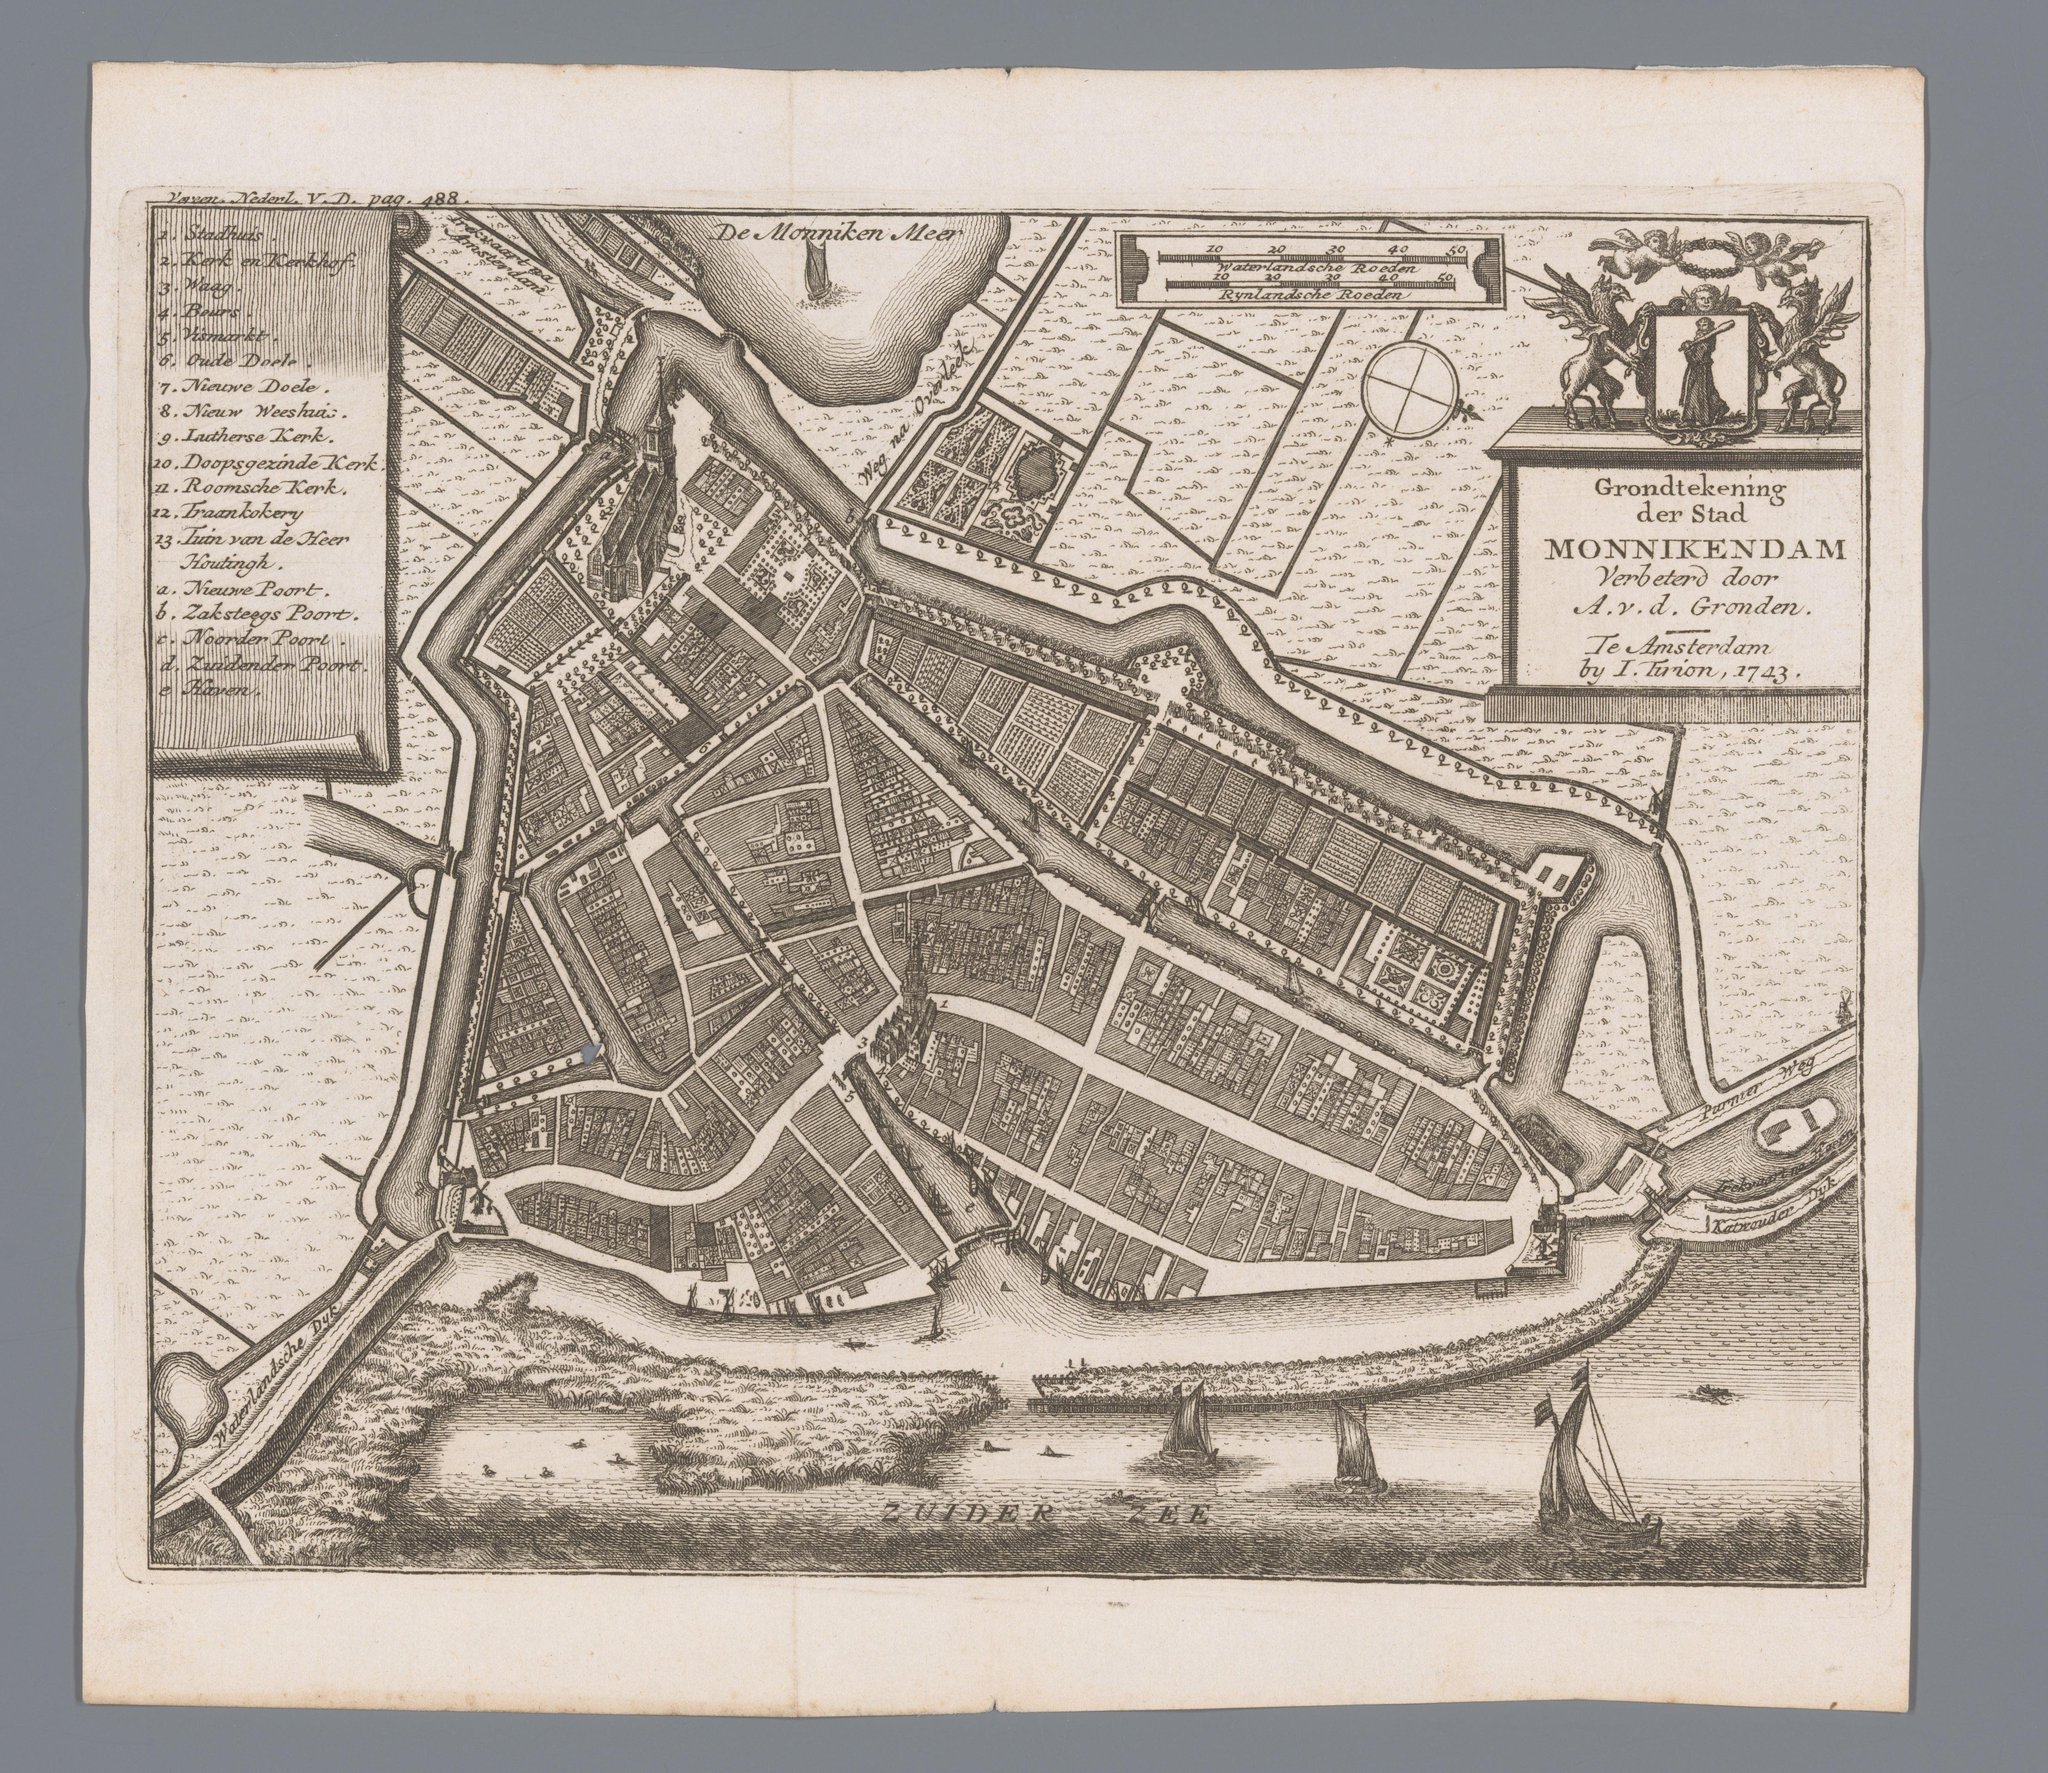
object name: area plan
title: Grondtekening der Stad Monnikendam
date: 1743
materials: paper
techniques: etching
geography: amsterdam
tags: maps of cities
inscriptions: collector's mark: Lugt 2228